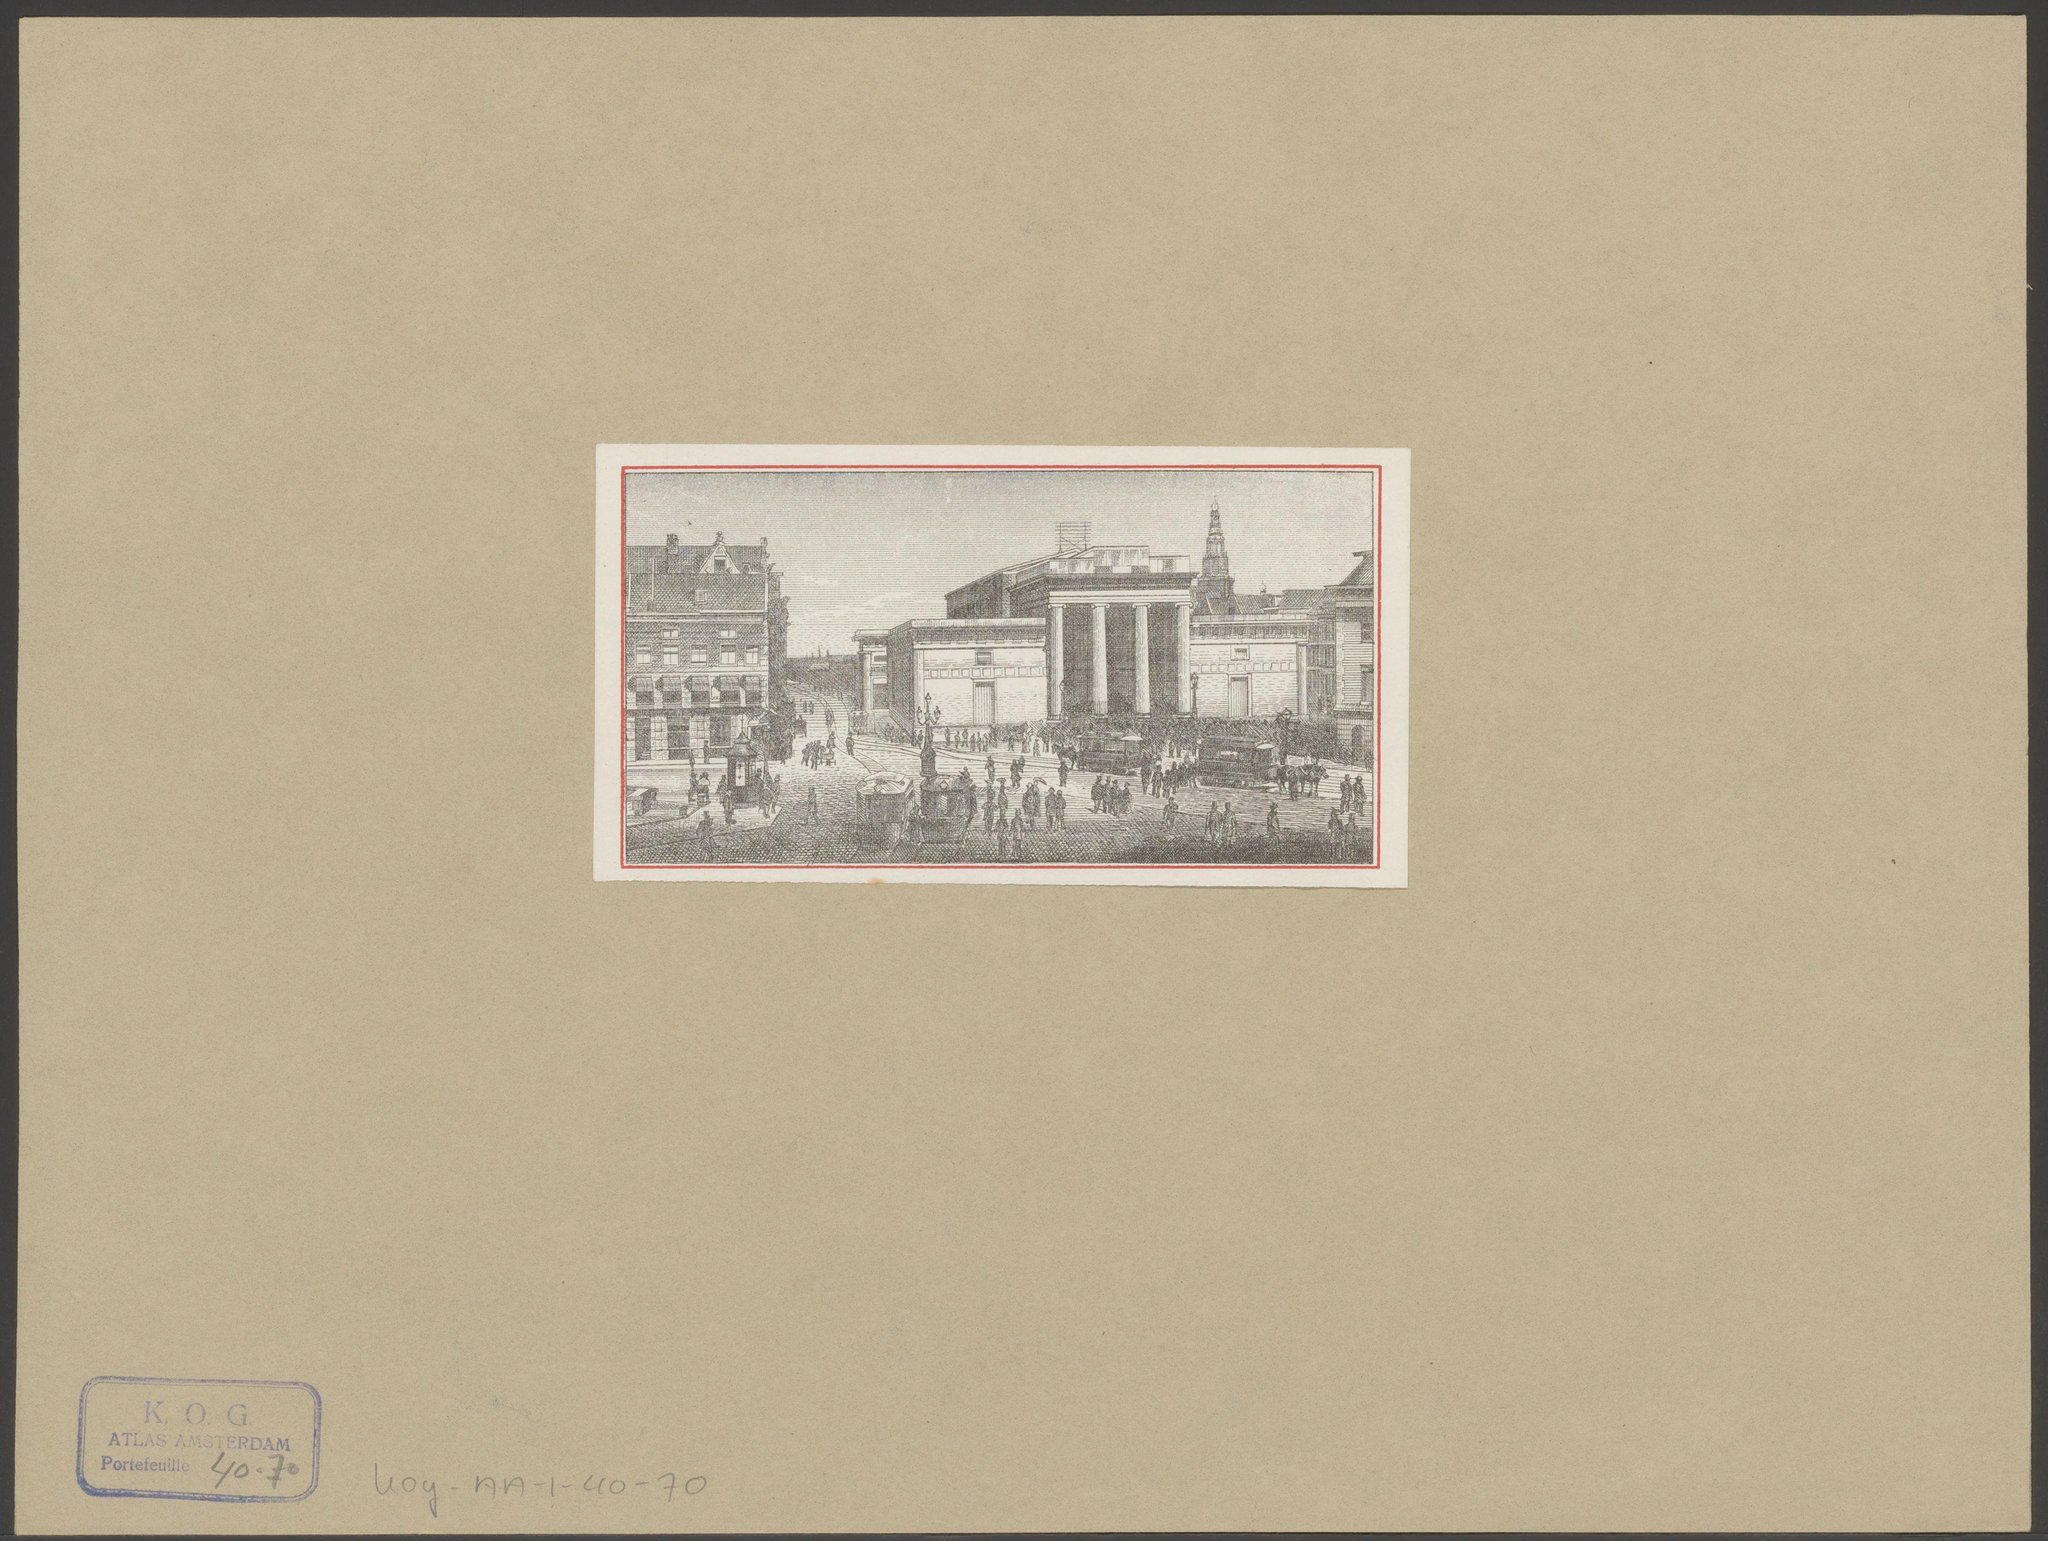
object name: price list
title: Gezicht op de Beurs van Zocher te Amsterdam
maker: Anonymous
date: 1845-1875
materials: paper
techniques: letterpress printing, printing block, engraving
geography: netherlands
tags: stock exchange, stock-market, square, place, circus, etc. (+ city(-scape) with figures, staffage)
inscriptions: collector's mark: Lugt 1641b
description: Gezicht op de Beurs van Zocher te Amsterdam met op verso een prijslijst voor verschillende wijnen en bubbelwijnen. Onderwerpsrubriek binnen de Atlas Amsterdam: Handel en Zeevaart: Hulpbeurs op de Dam en Beurs (Dam).